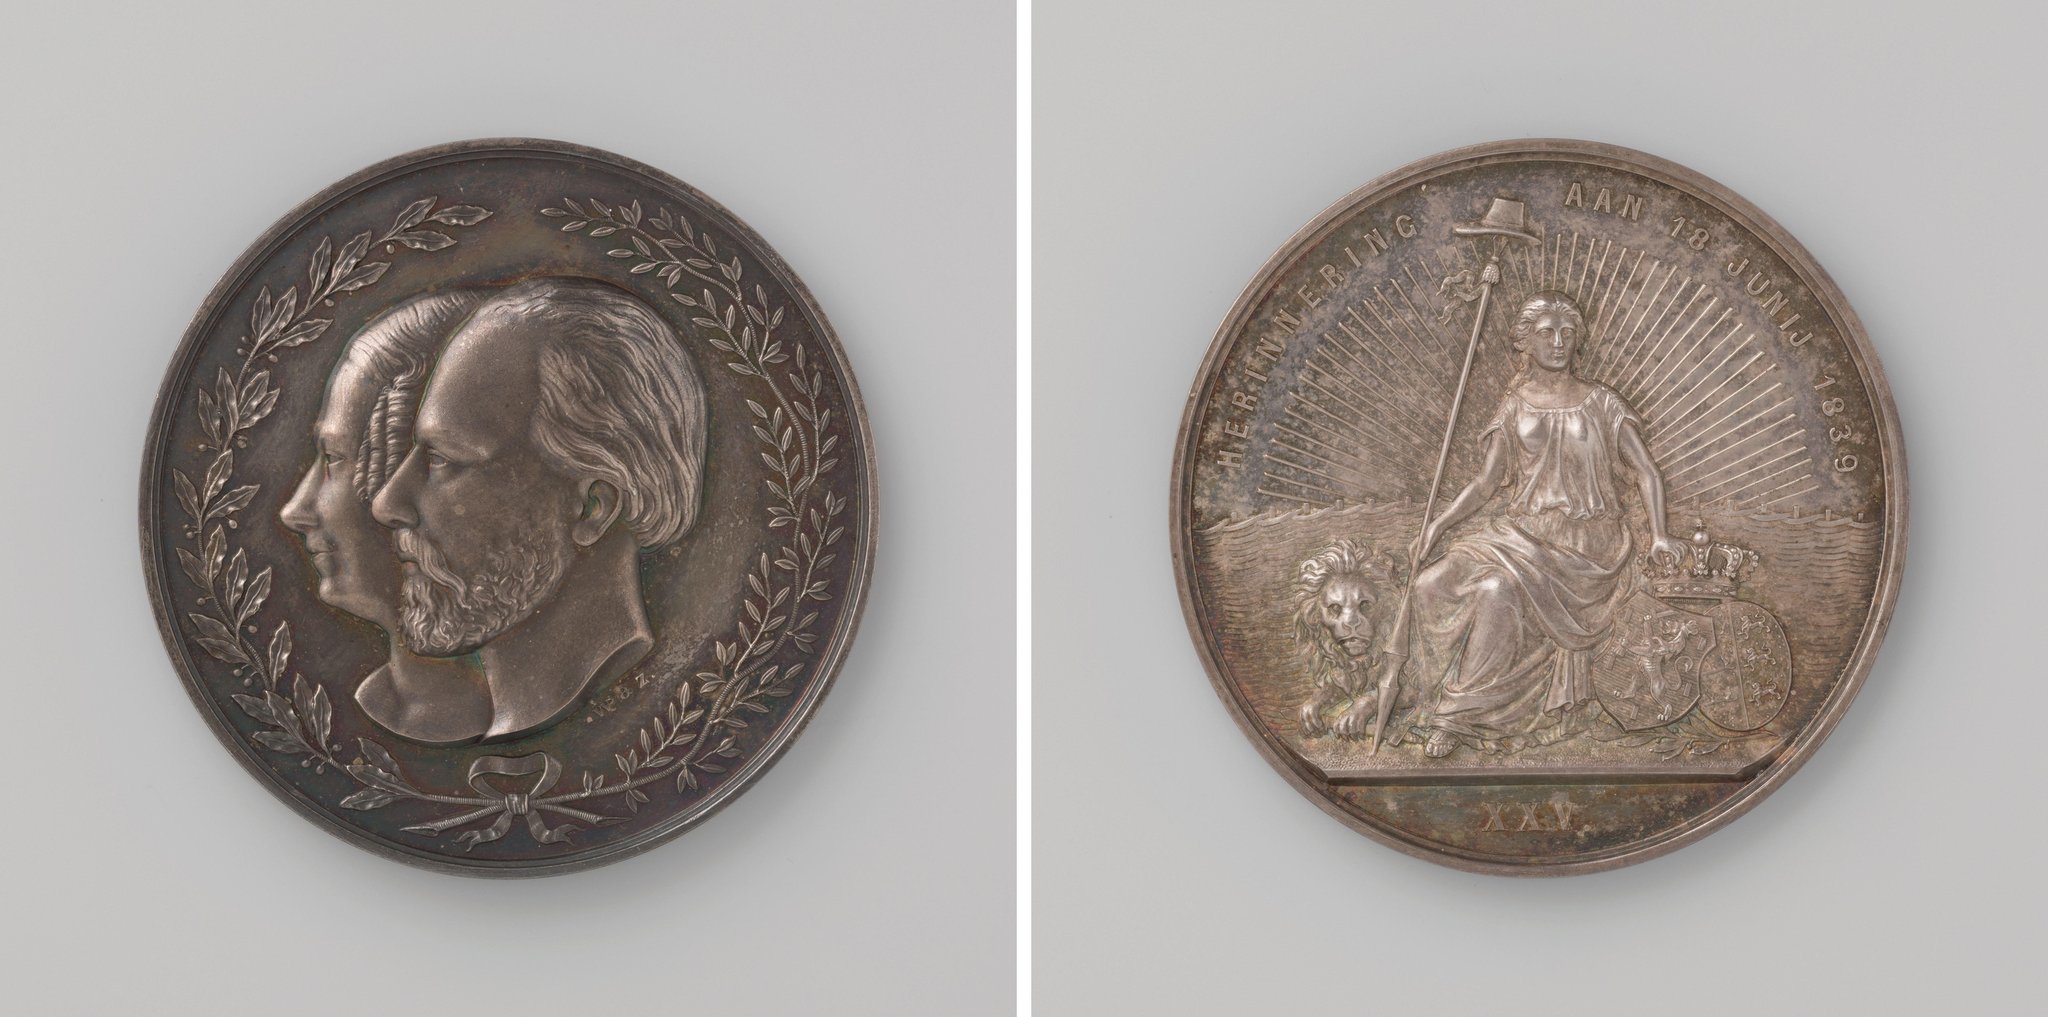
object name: history medal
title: Vijfentwintigjarig huwelijk van Willem III en Sophia Frederika Mathilda, koning en koningin der Nederlanden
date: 1864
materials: silver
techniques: striking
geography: amsterdam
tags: brussels, willem iii (koning der nederlanden), sophia frederika mathilda van württemberg, netherlands